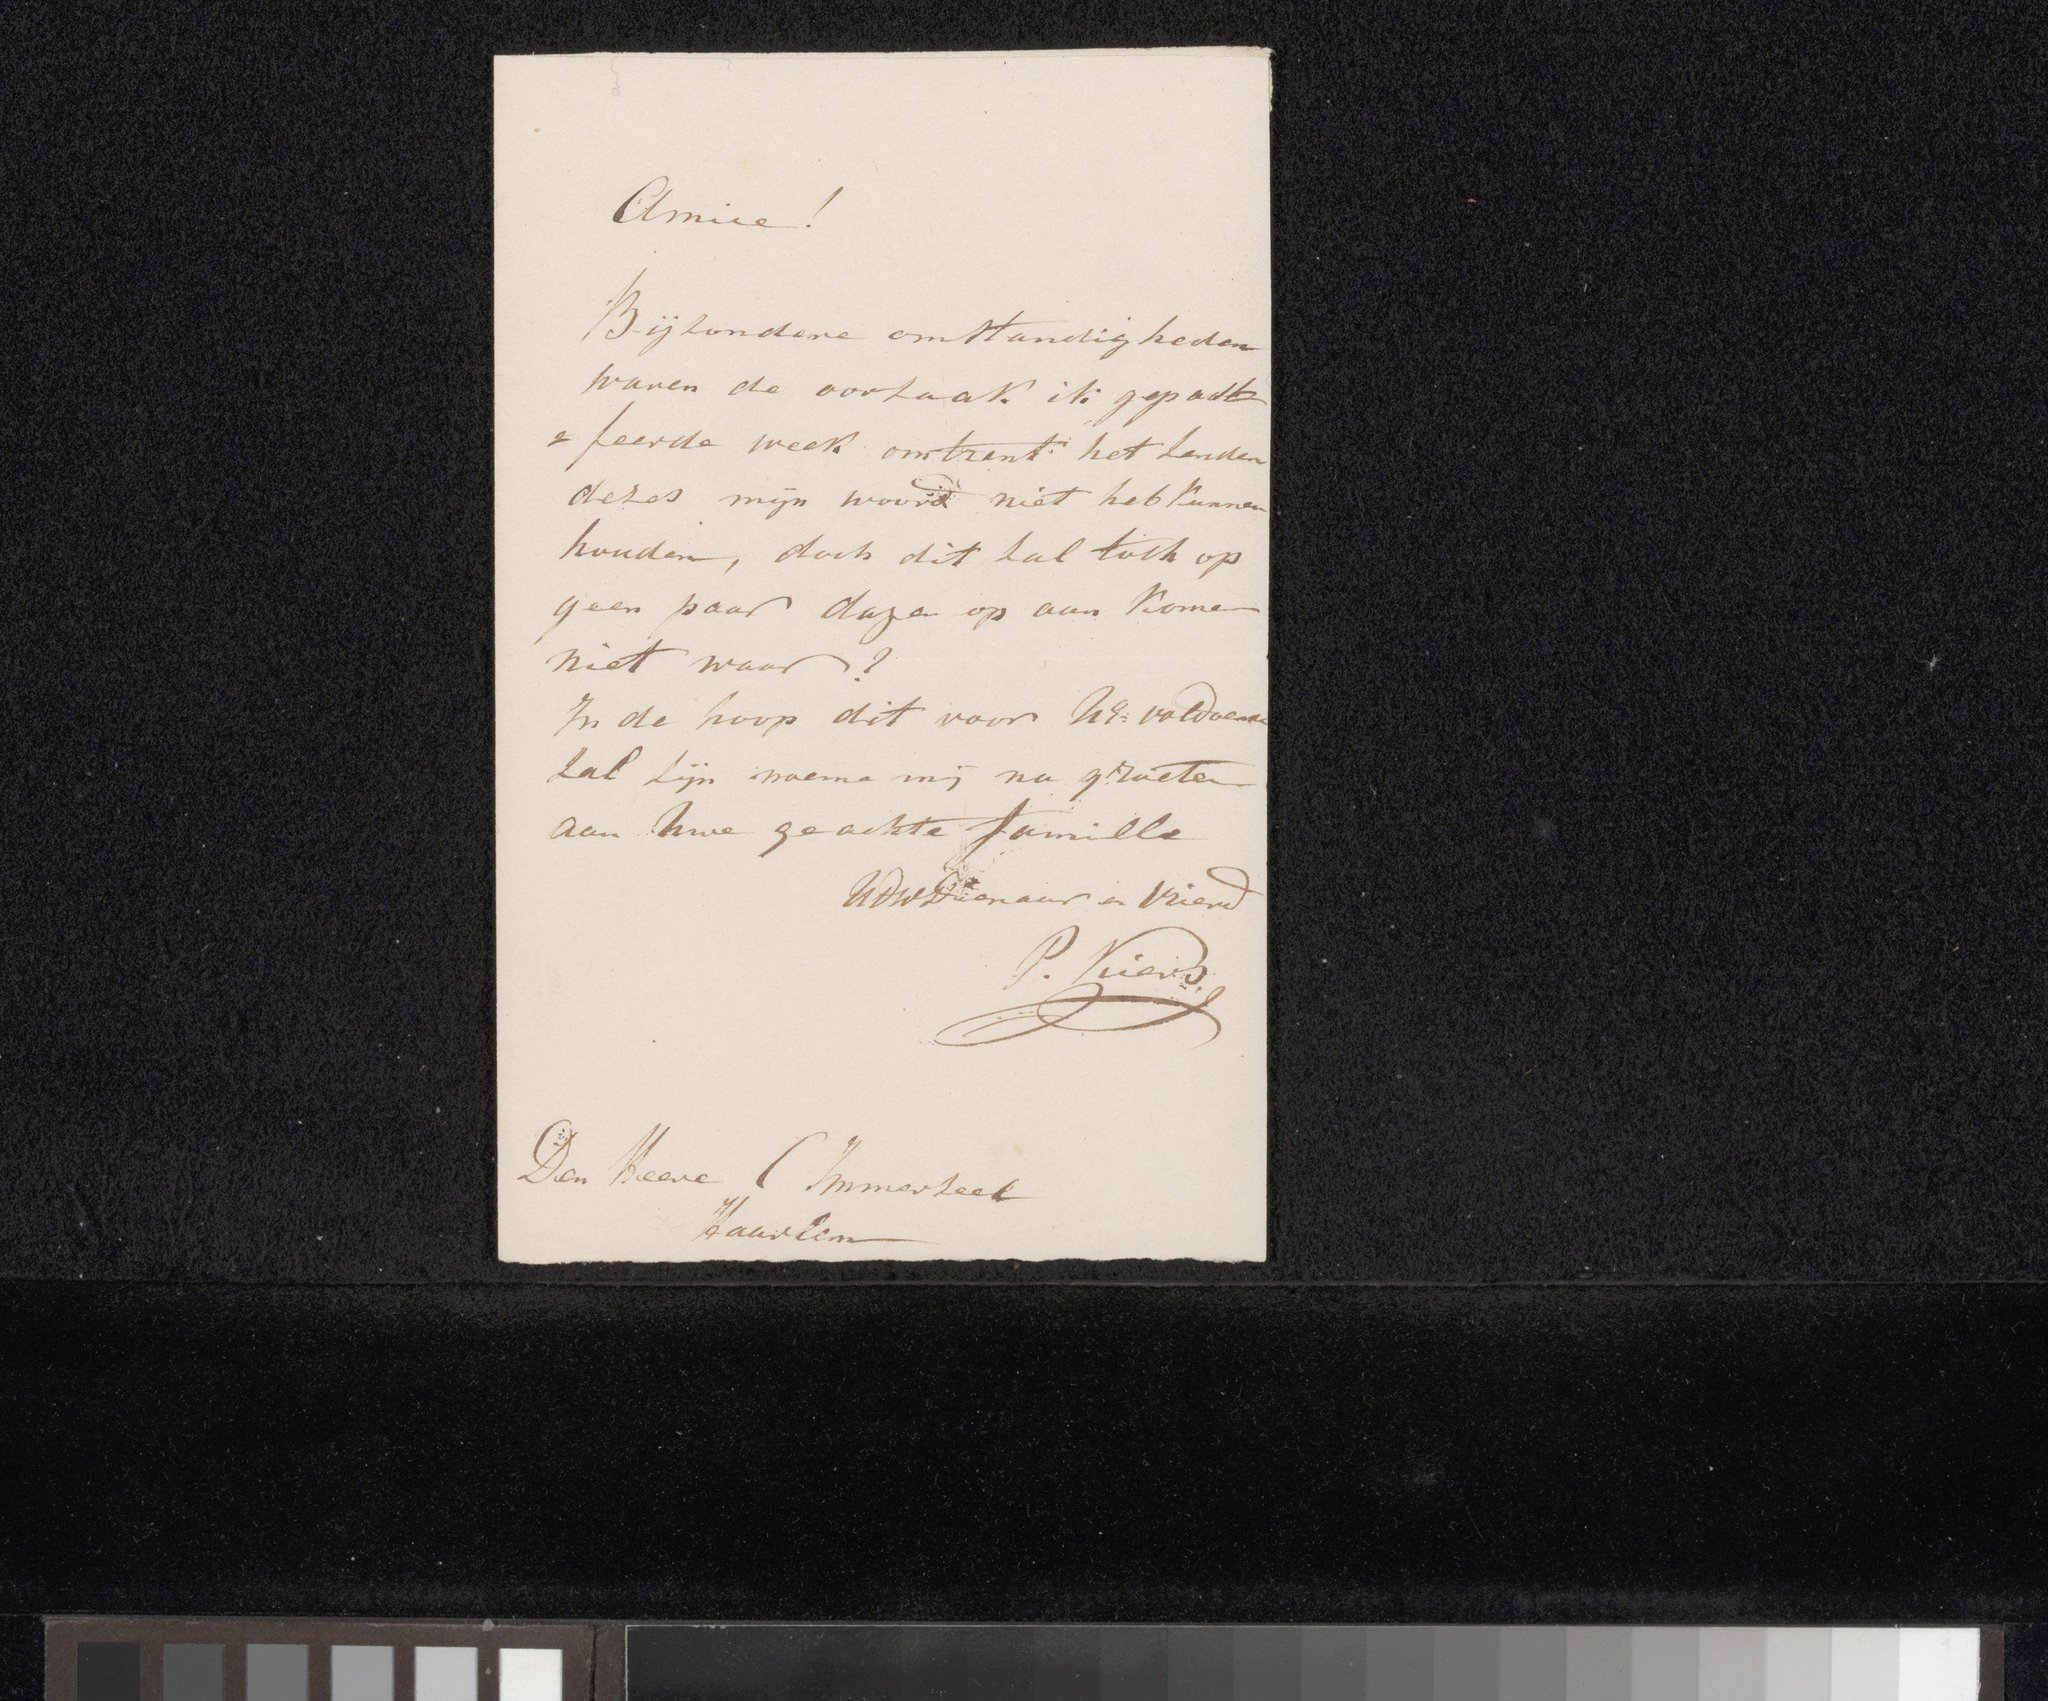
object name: letter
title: Brief aan Christiaan Immerzeel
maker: petrus kiers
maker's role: draughtsman, painter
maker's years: 1807-1875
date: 1818-1875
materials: ink, paper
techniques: pen, writing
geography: amsterdam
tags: print maker, christiaan immerzeel